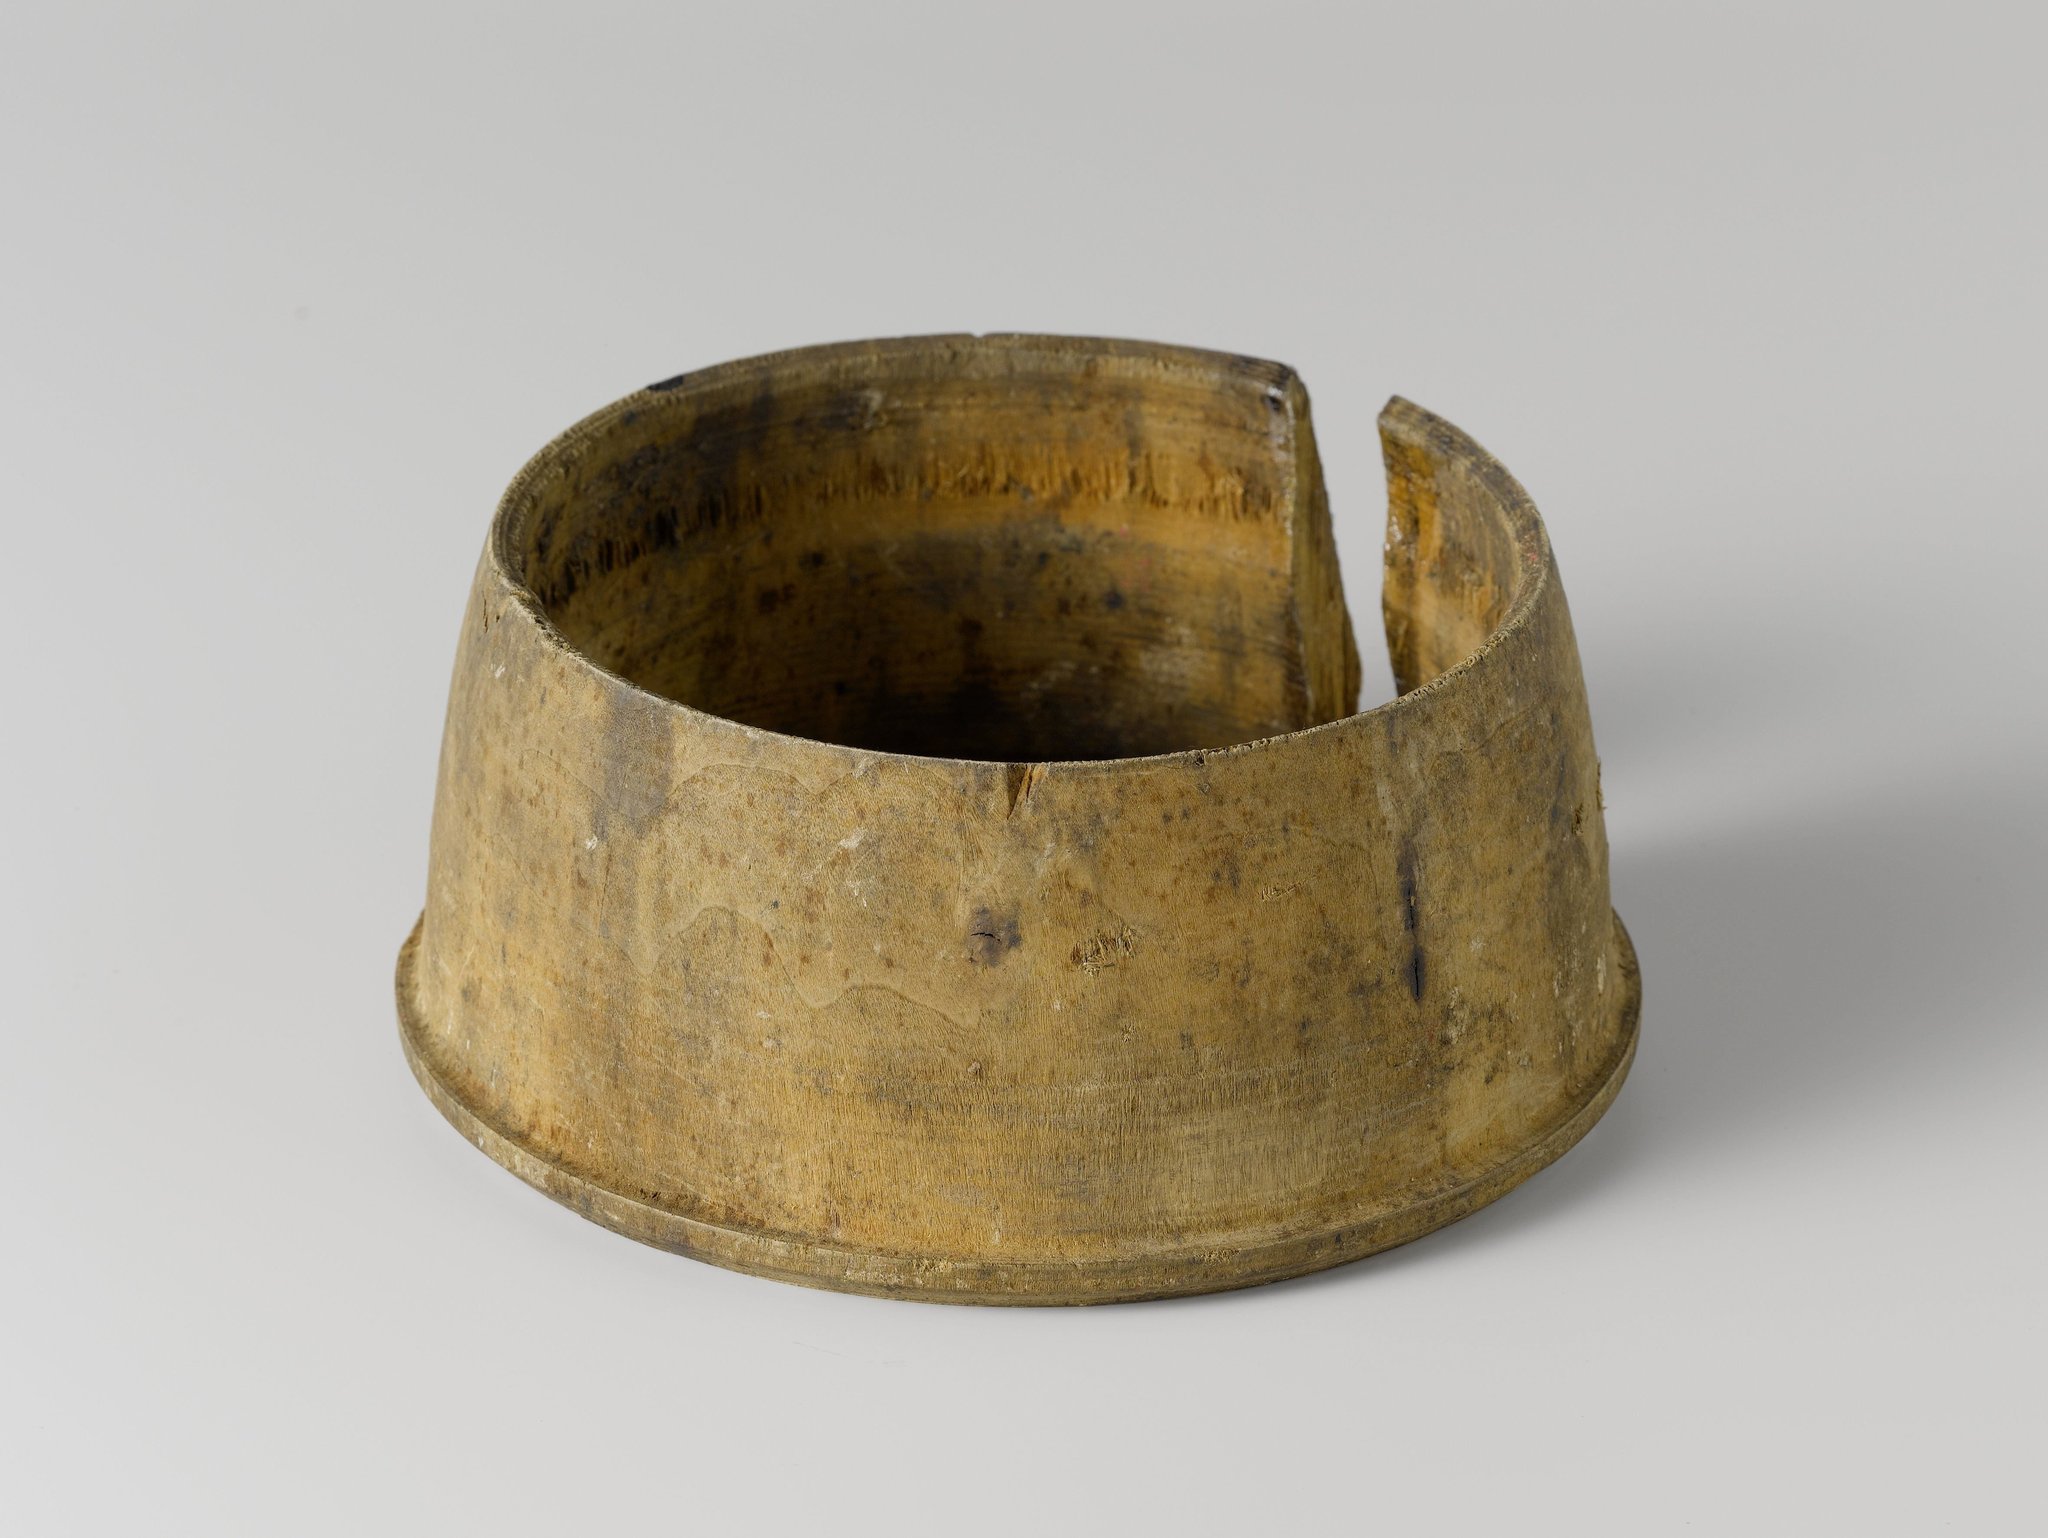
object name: kompasdoos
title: Kompasdoos met een opening aan de onder- en bovenzijde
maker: Anonymous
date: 1590-1596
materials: wood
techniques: turning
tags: willem barendsz., amsterdam, jacob van heemskerck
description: Kompasdoos rond van vorm met een licht gebogen wand en een opening aan de onder- en bovenzijde. De bovenkant van de doos heeft een uitstekende rand. Er ontbreekt een stuk uit de wand. Het object is identiek aan NM-7794-1, maar groter van formaat.